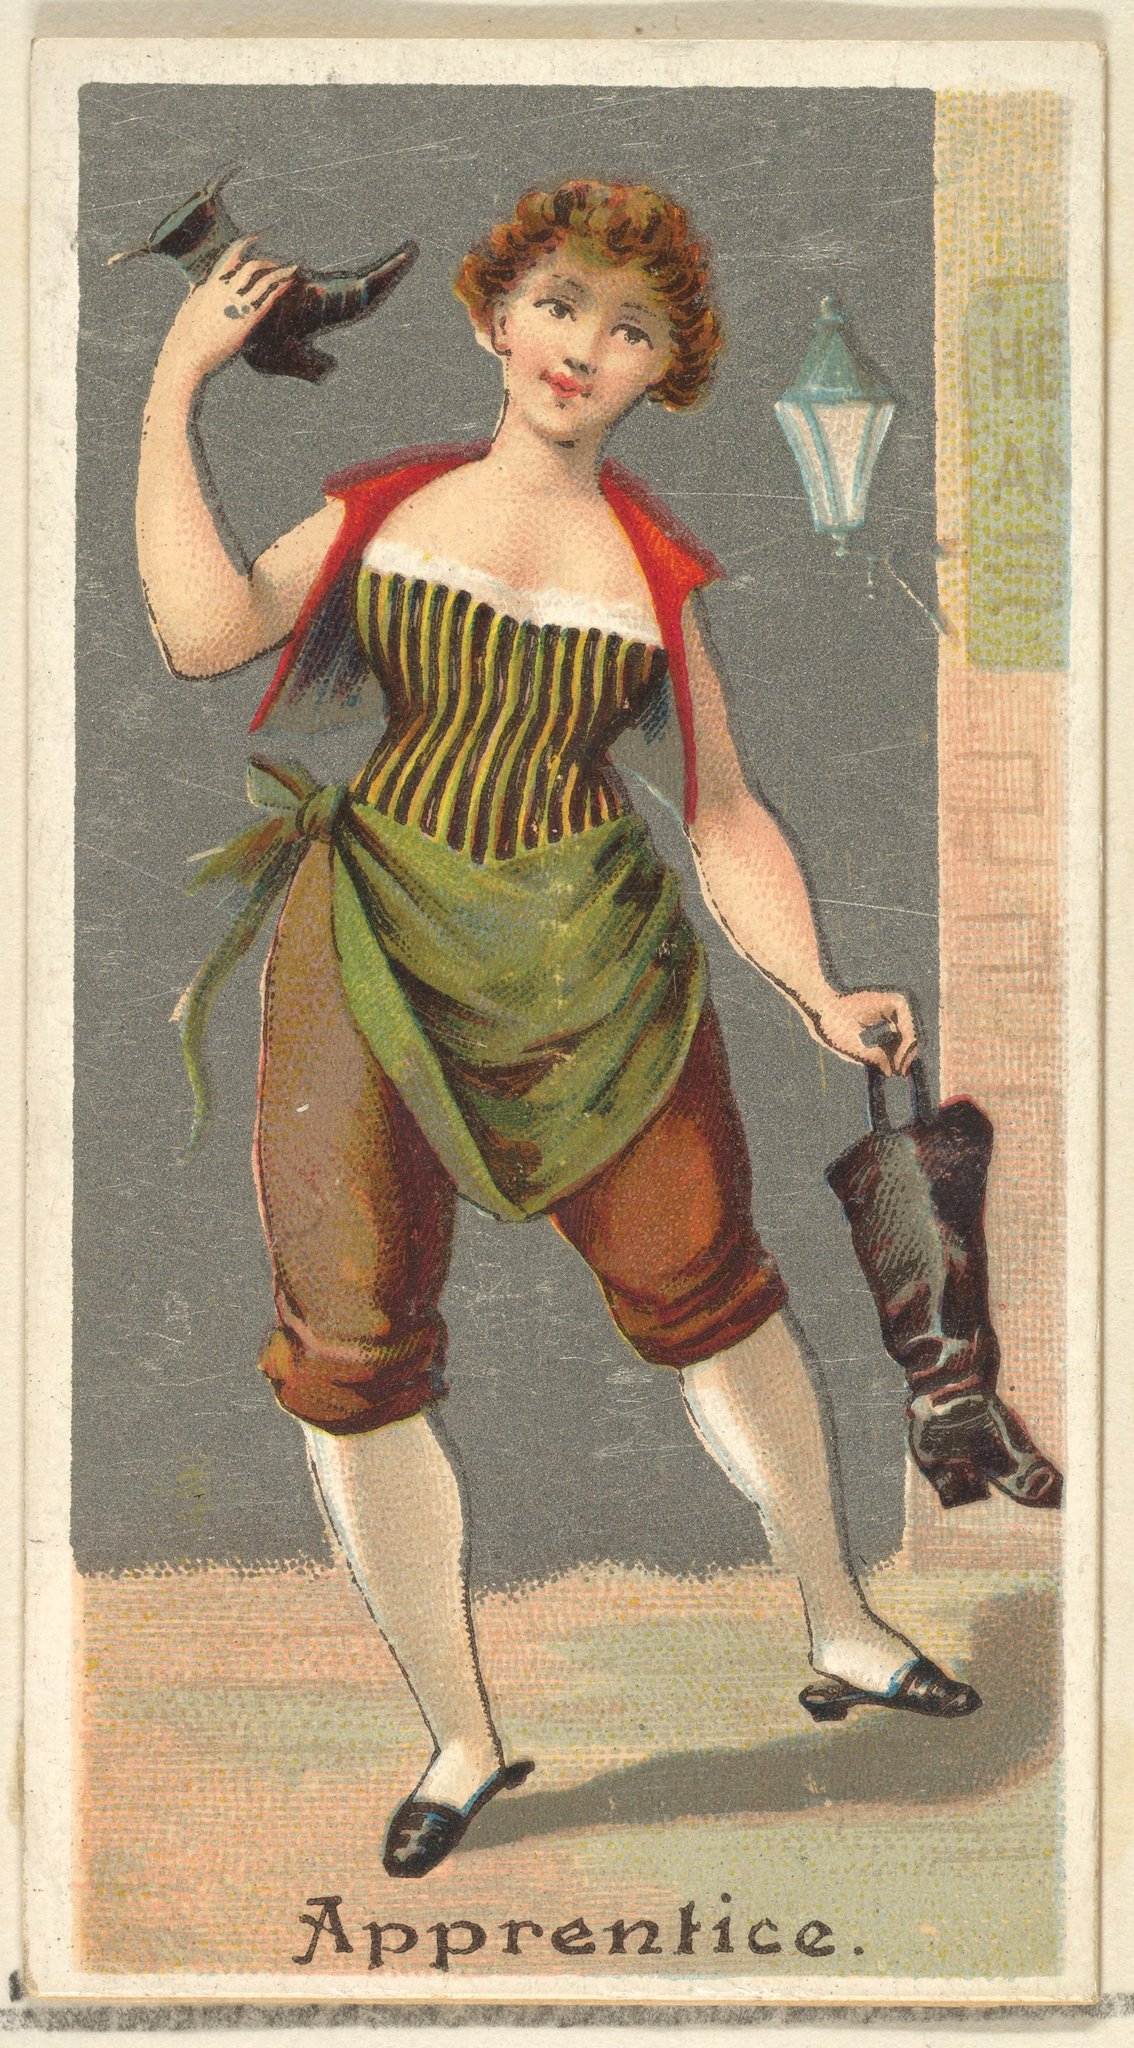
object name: print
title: Apprentice, from the Occupations for Women series (N166) for Old Judge and Dogs Head Cigarettes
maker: goodwin & company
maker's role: publisher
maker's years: 1850-1950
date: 1887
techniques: color lithograph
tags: boots,women